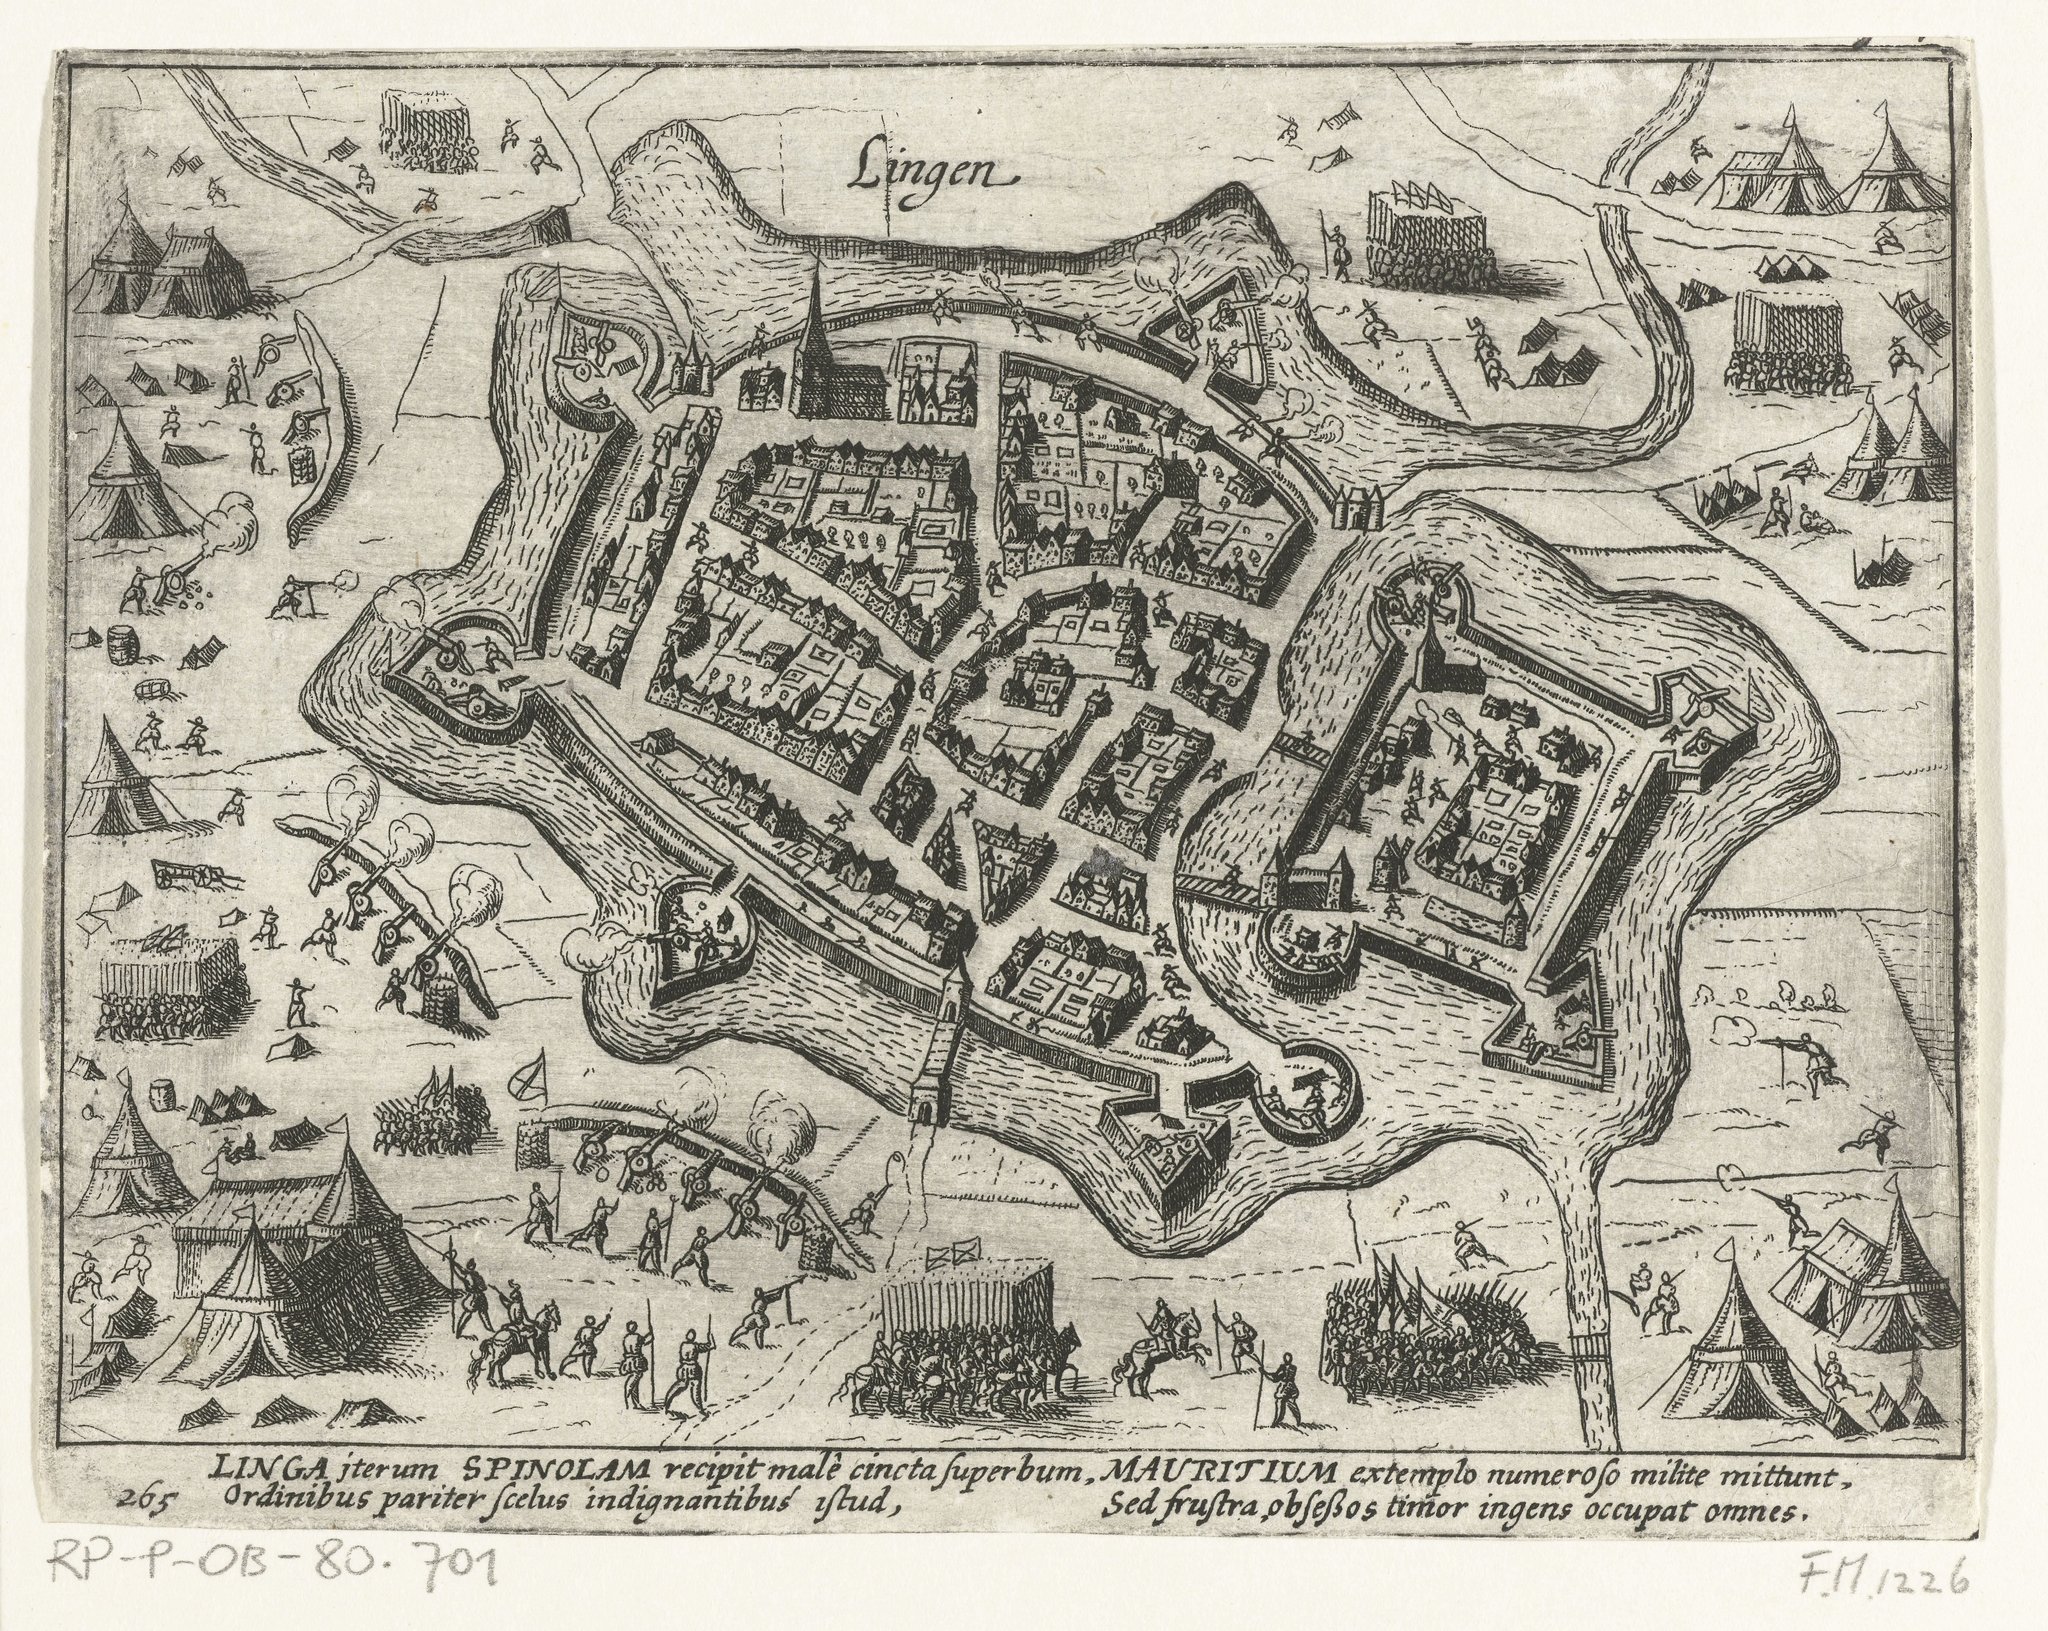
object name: print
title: Lingen door Spinola ingenomen, 1605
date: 1613-1615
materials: paper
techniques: etching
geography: northern netherlands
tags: siege, position war, maps of cities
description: Verovering van Lingen door Spinola, 21 augustus, 1605. Plan van de stad met de belegeraars in het omliggende land. Met onderschrift van 4 regels in het Latijn. Genummerd 265. Bedrukt op achterzijde met tekst in het Latijn.